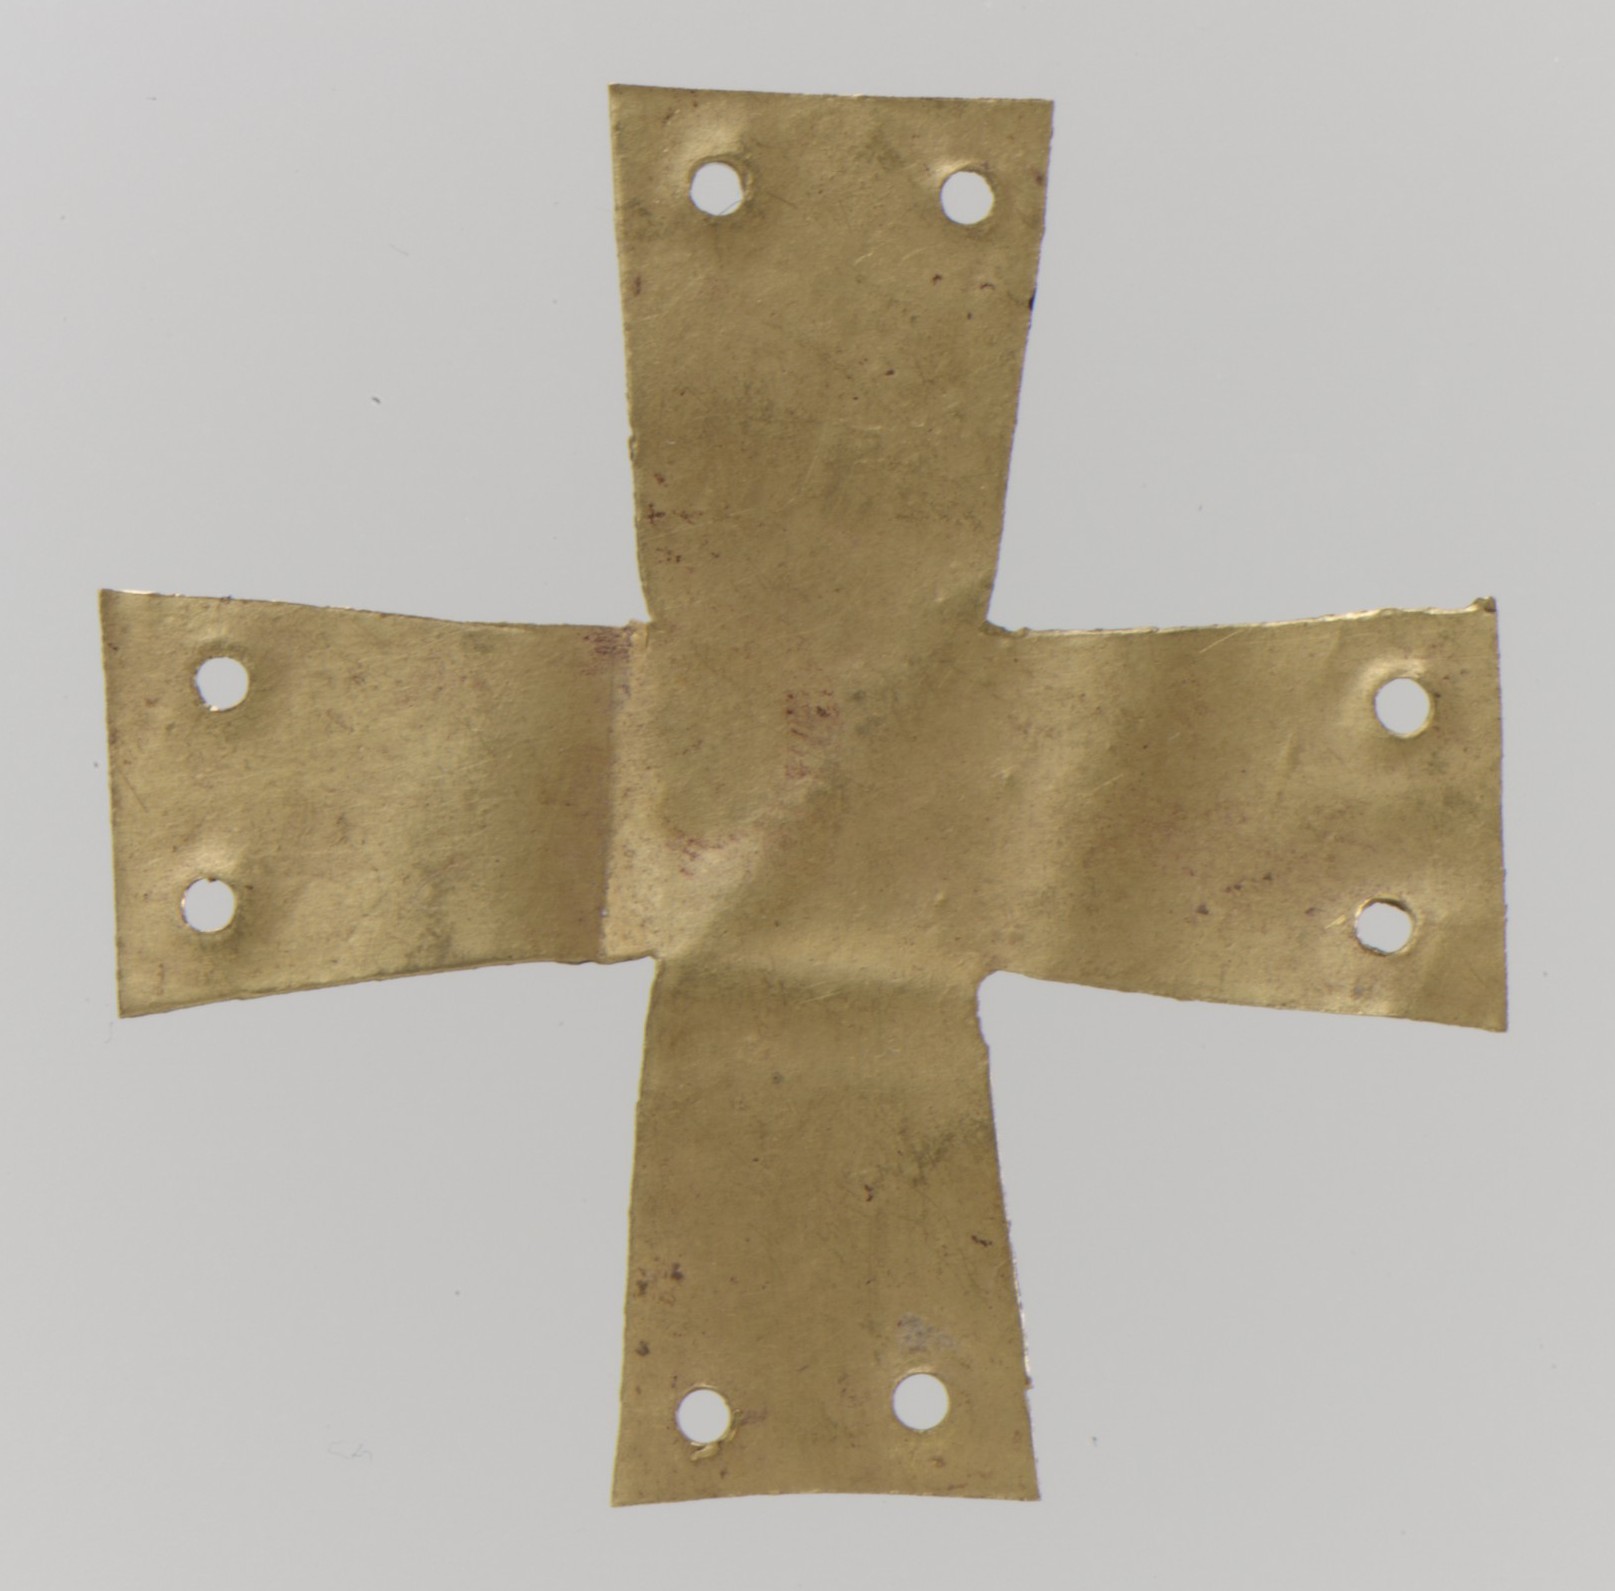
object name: appliqué cross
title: Gold Appliqué in the Form of a Cross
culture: langobardic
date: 600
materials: gold